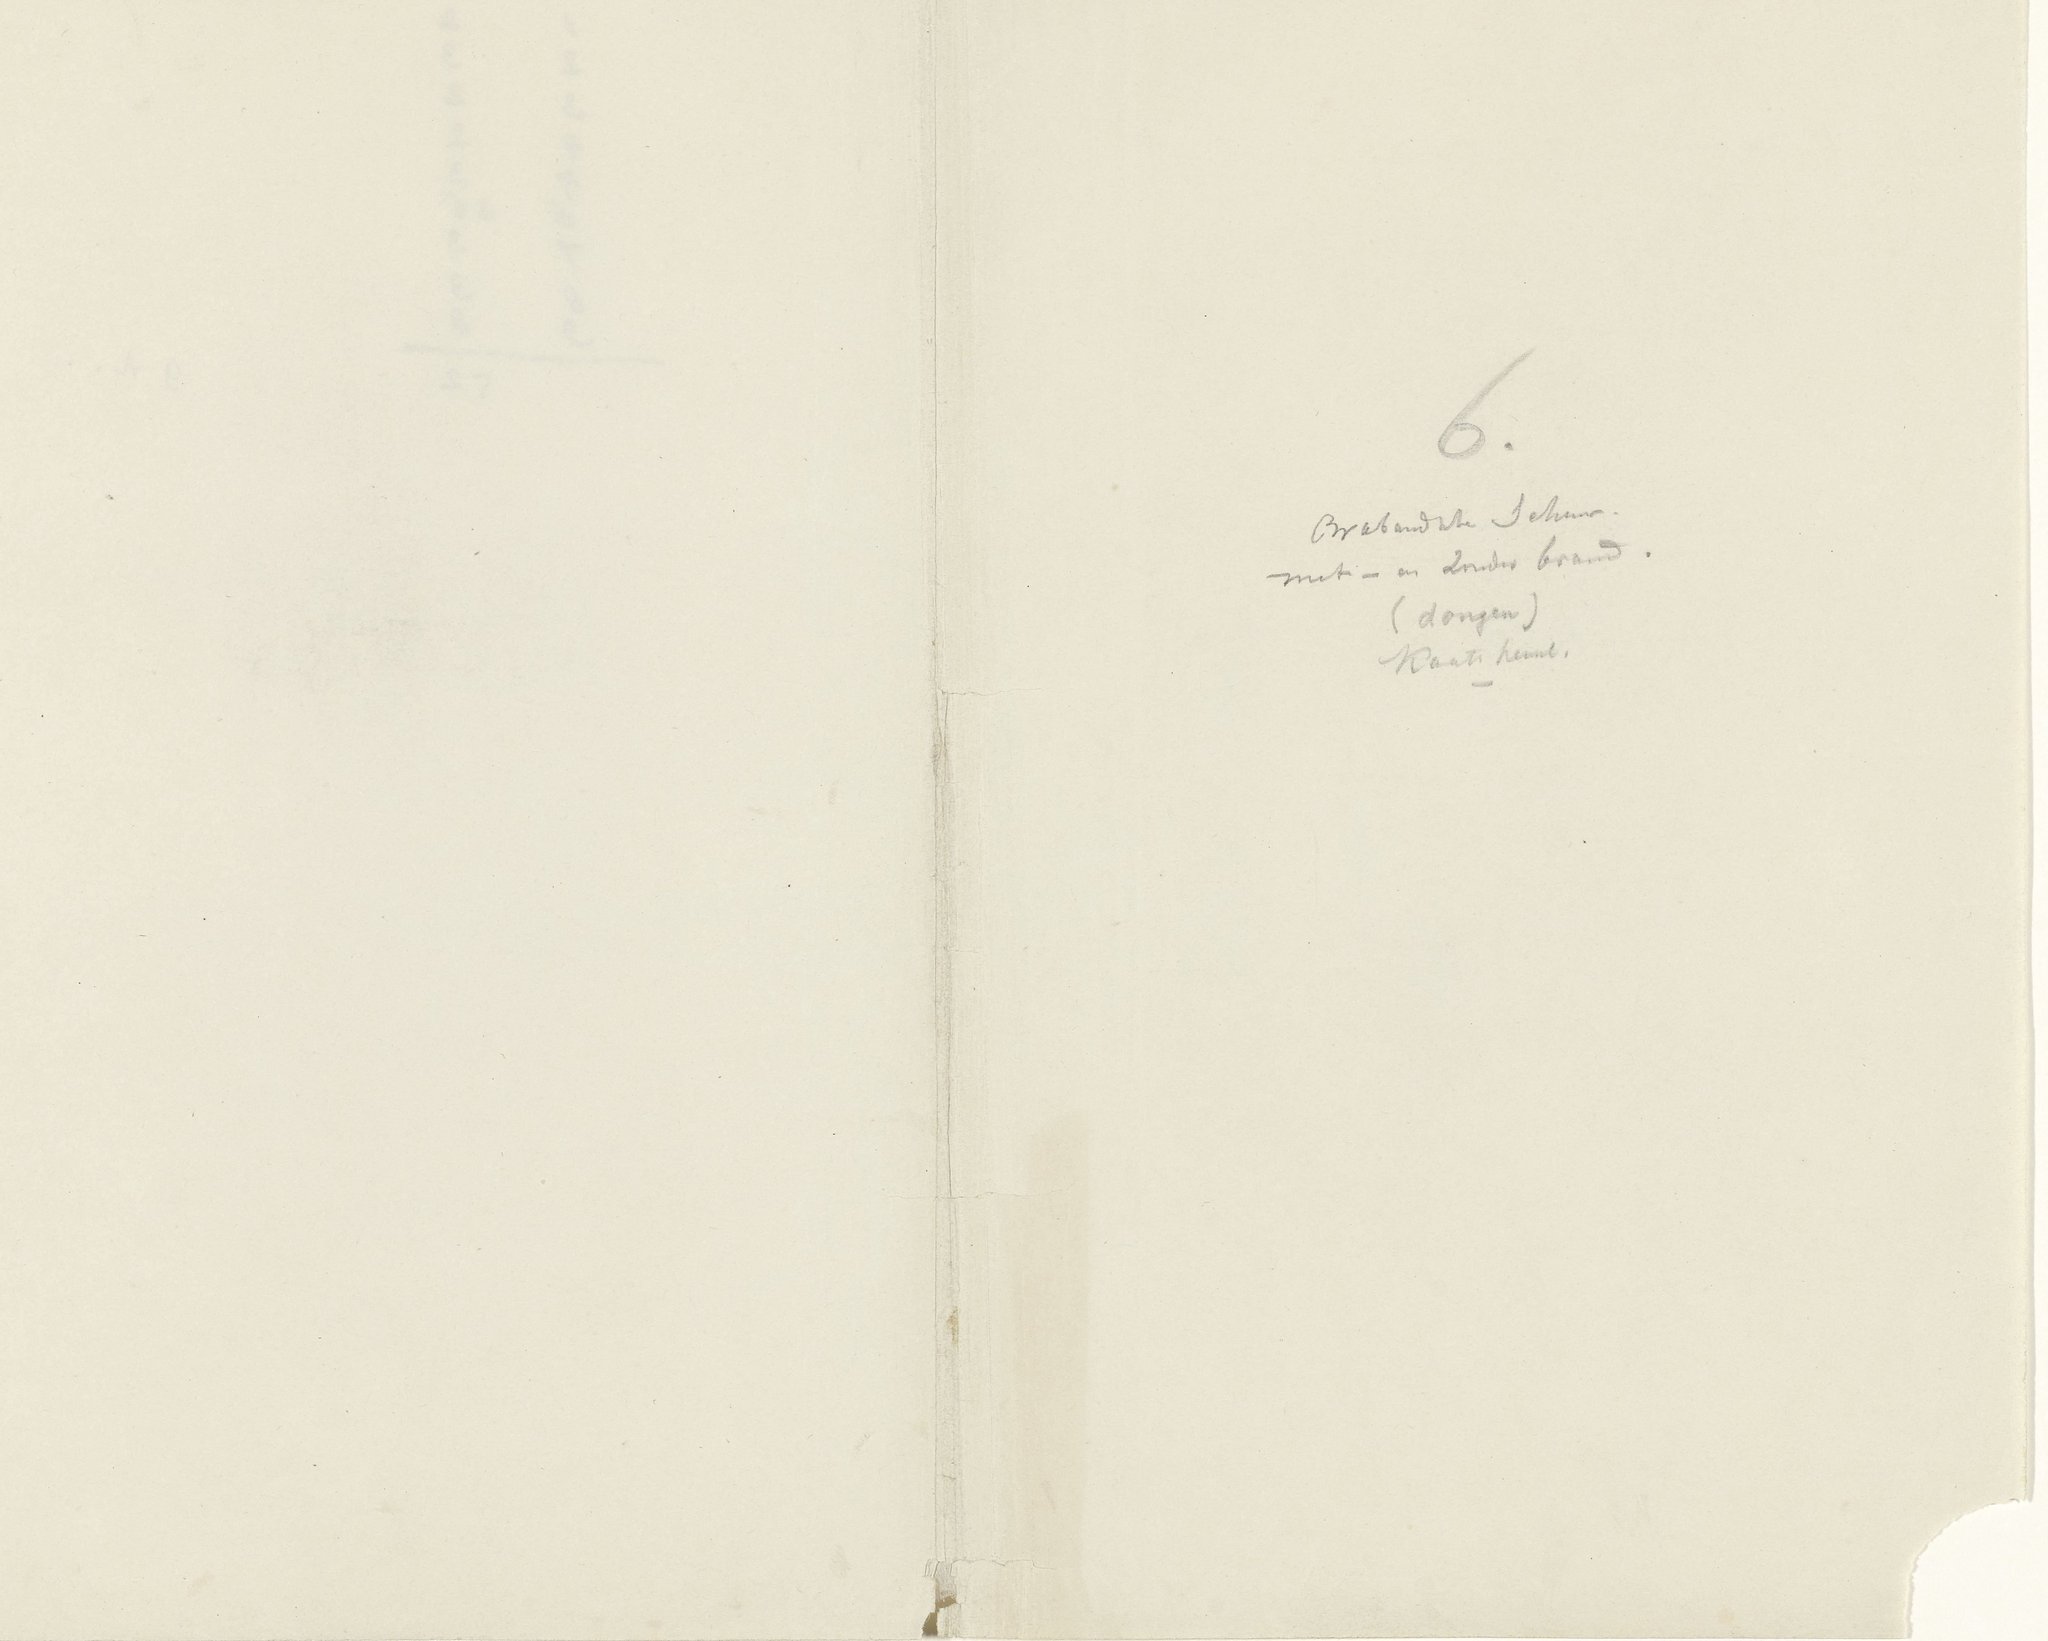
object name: wrapper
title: 6. Brabandsche Schuur met en zonder brand (dongen) Kaatsheuvel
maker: cornelis van der griendt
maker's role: draughtsman, painter, print maker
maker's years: 1827-1918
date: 1858-1918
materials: paper, pencil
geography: netherlands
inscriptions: inscription: ‘[...] 52, 9 [...]’